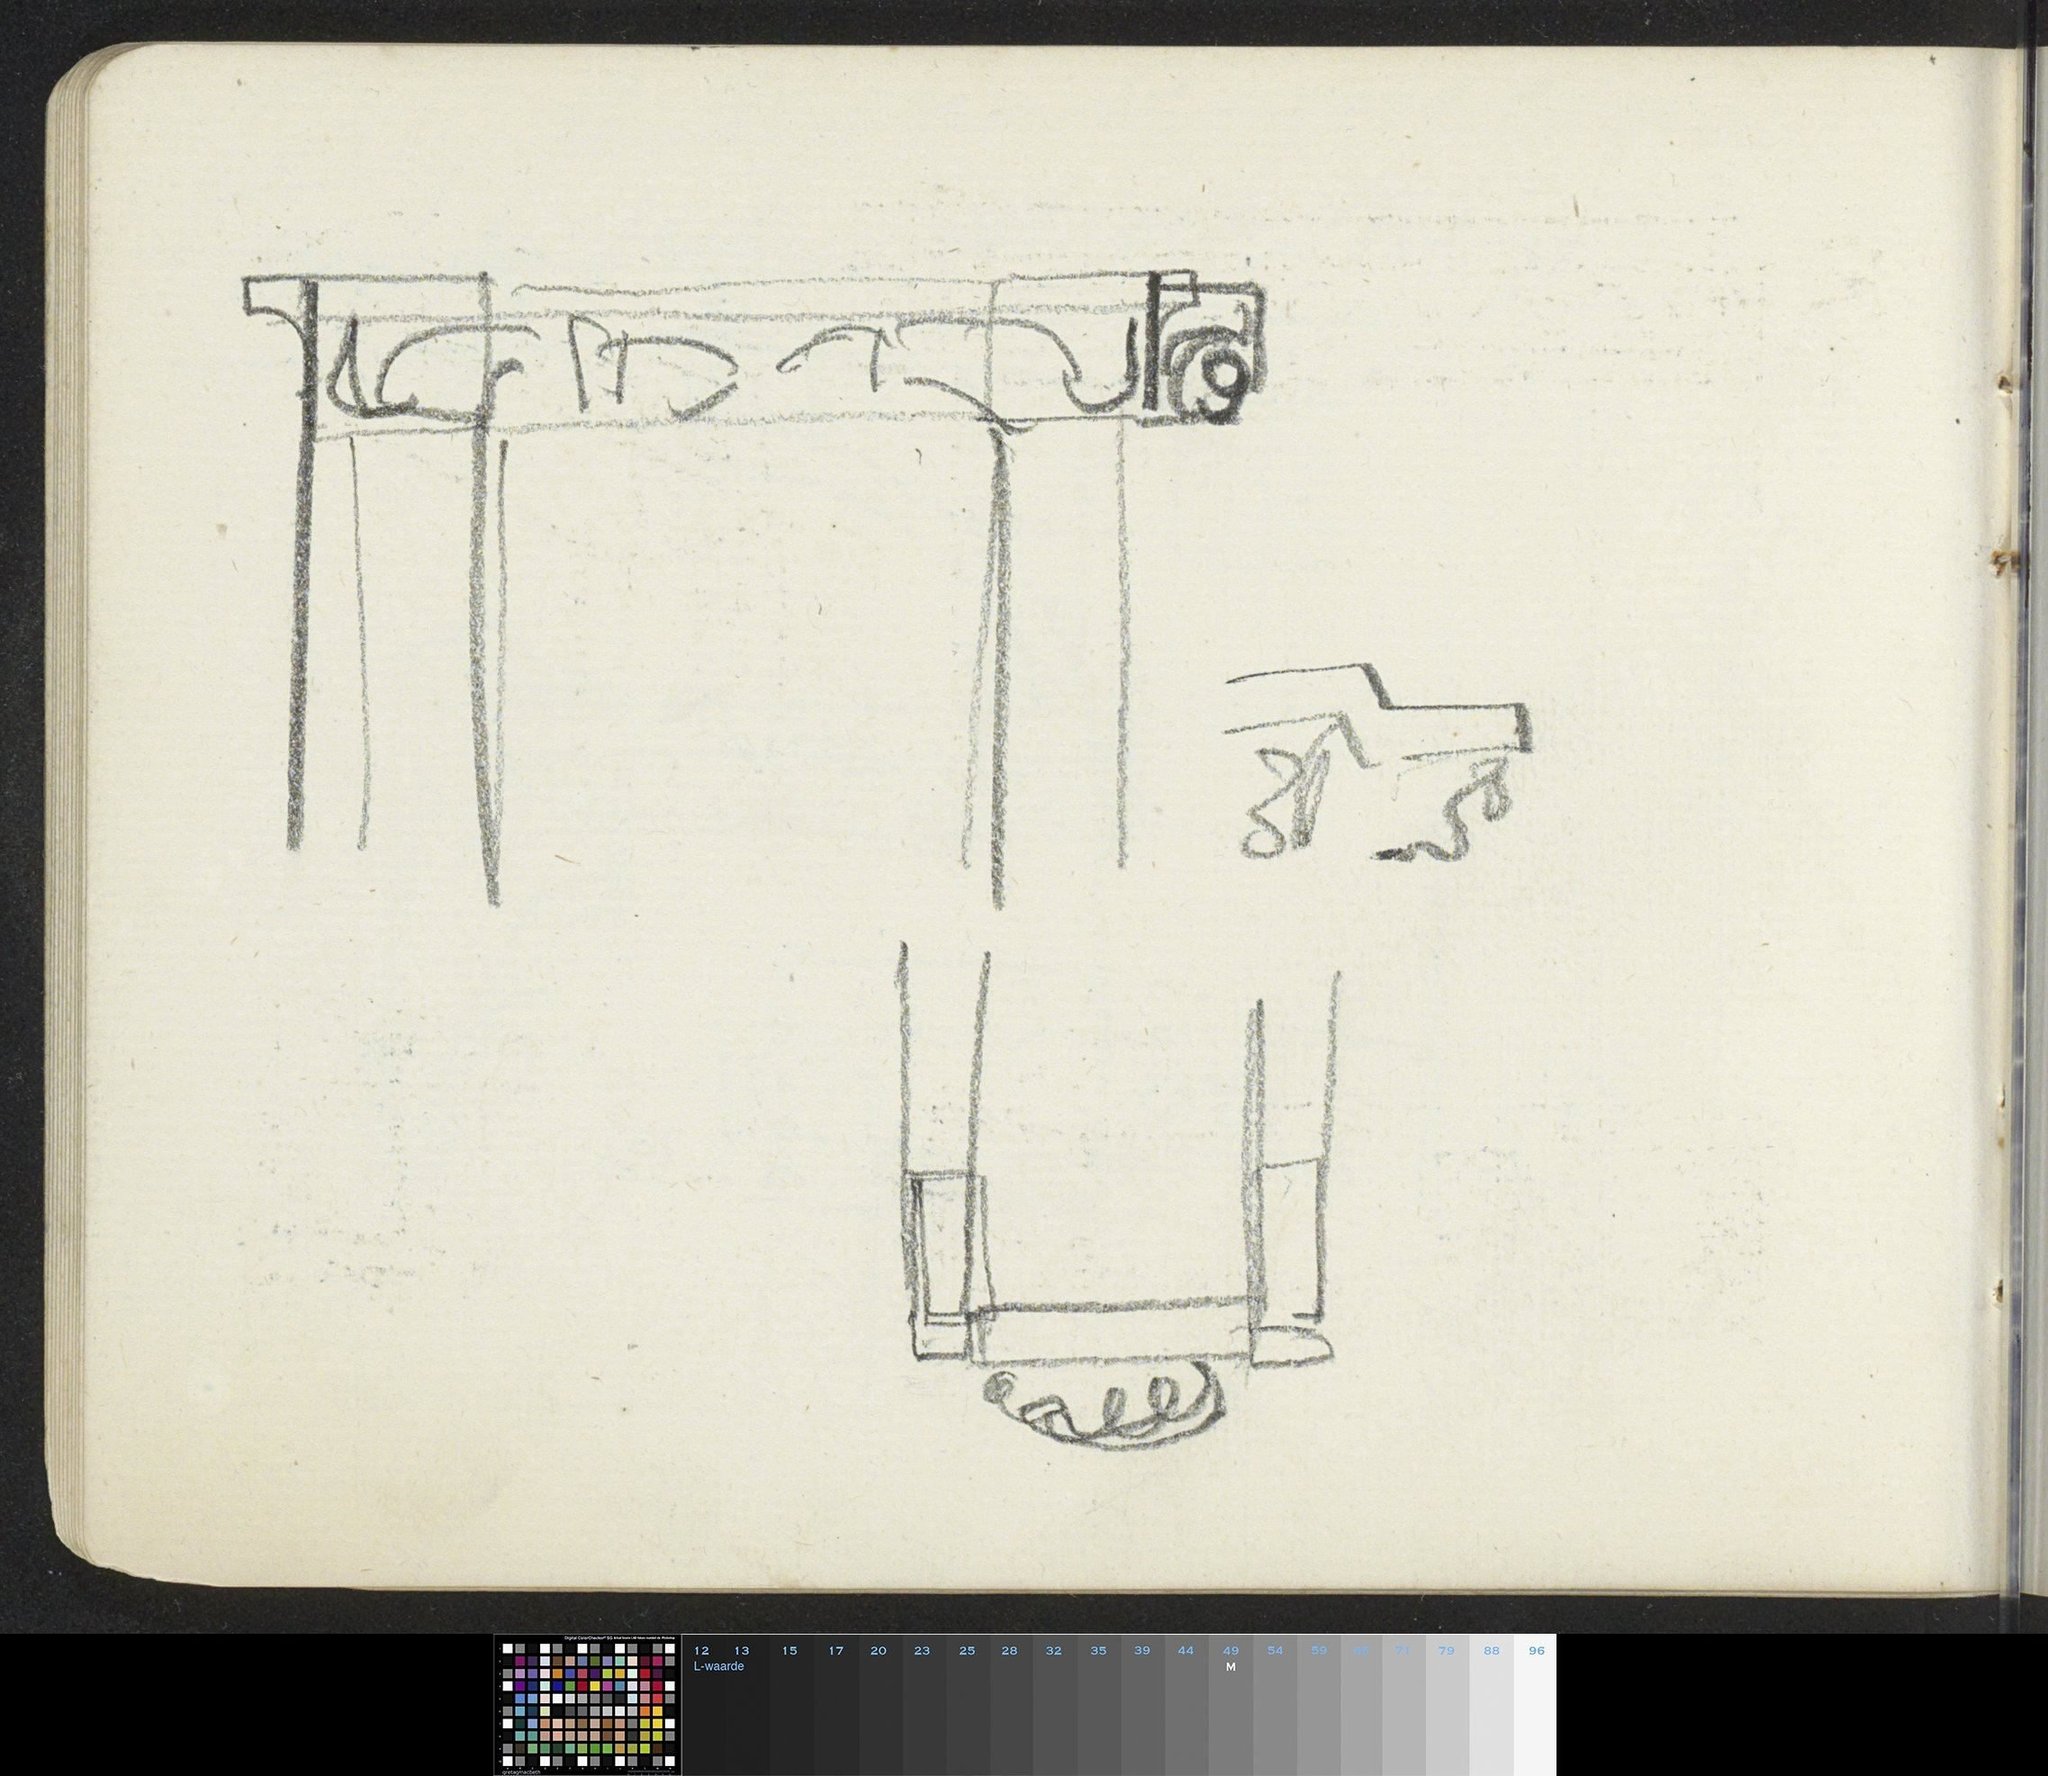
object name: sketchbook leaf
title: Ontwerp voor een schoorsteenmantel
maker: carel adolph lion cachet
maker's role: draughtsman, print maker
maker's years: 1864-1945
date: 1928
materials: paper, pencil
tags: chimney-piece, mantelpiece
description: Blad 10 verso uit een schetsboek met 24 bladen.